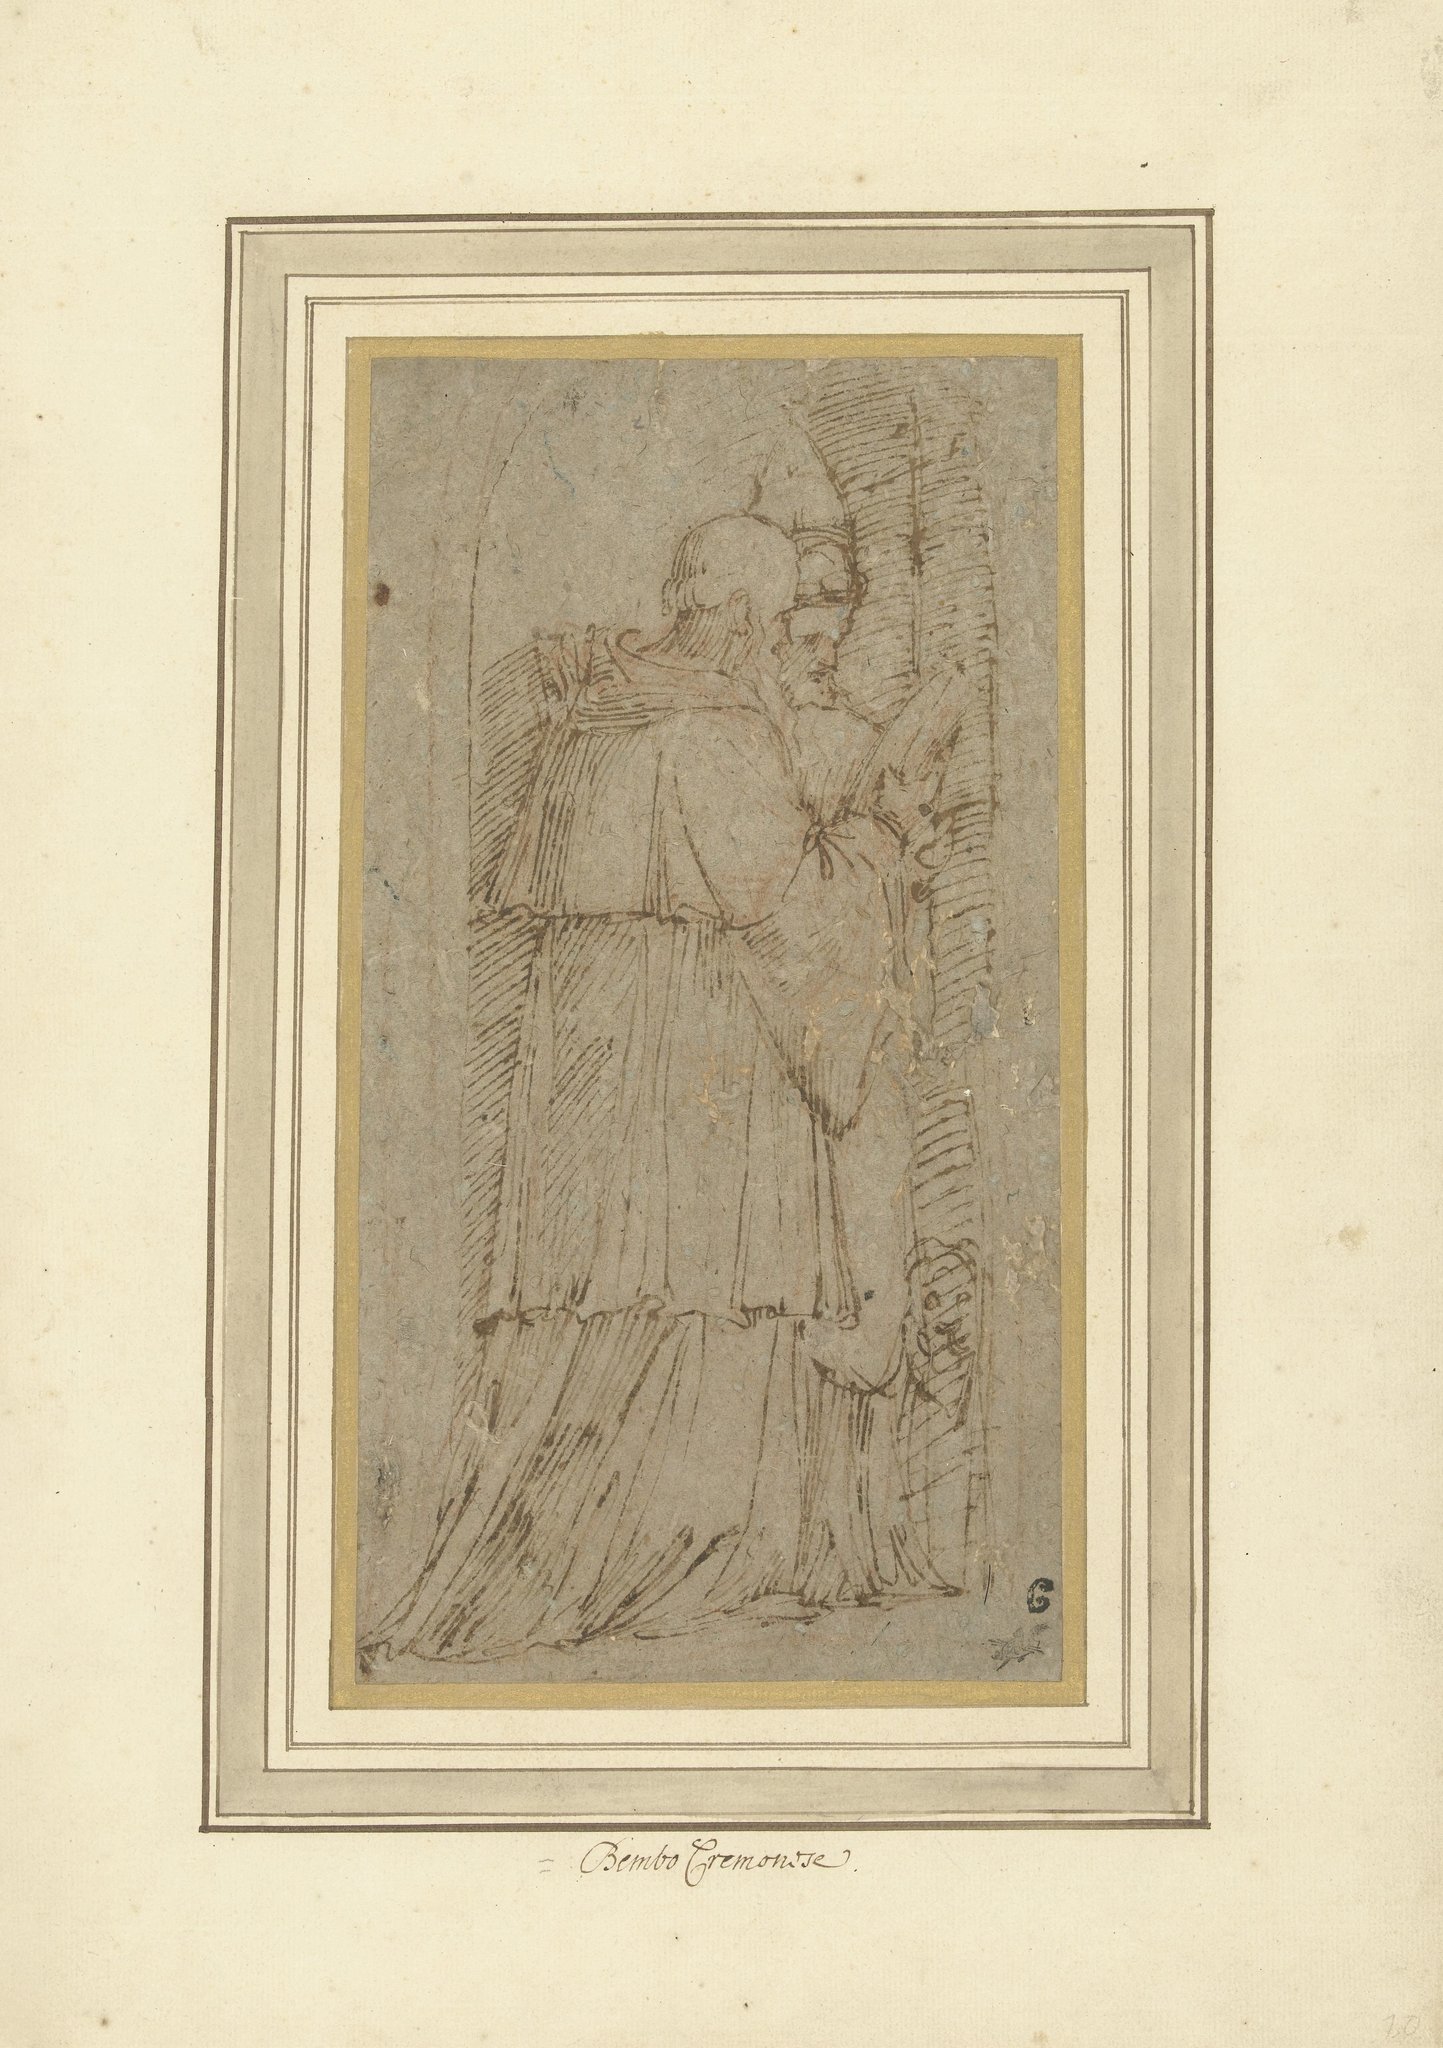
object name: drawing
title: Kerkvaders Hieronymus en Gregorius in een portaal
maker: gian francesco bembo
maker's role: draughtsman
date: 1500-1525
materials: chalk, ink, paper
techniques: pen